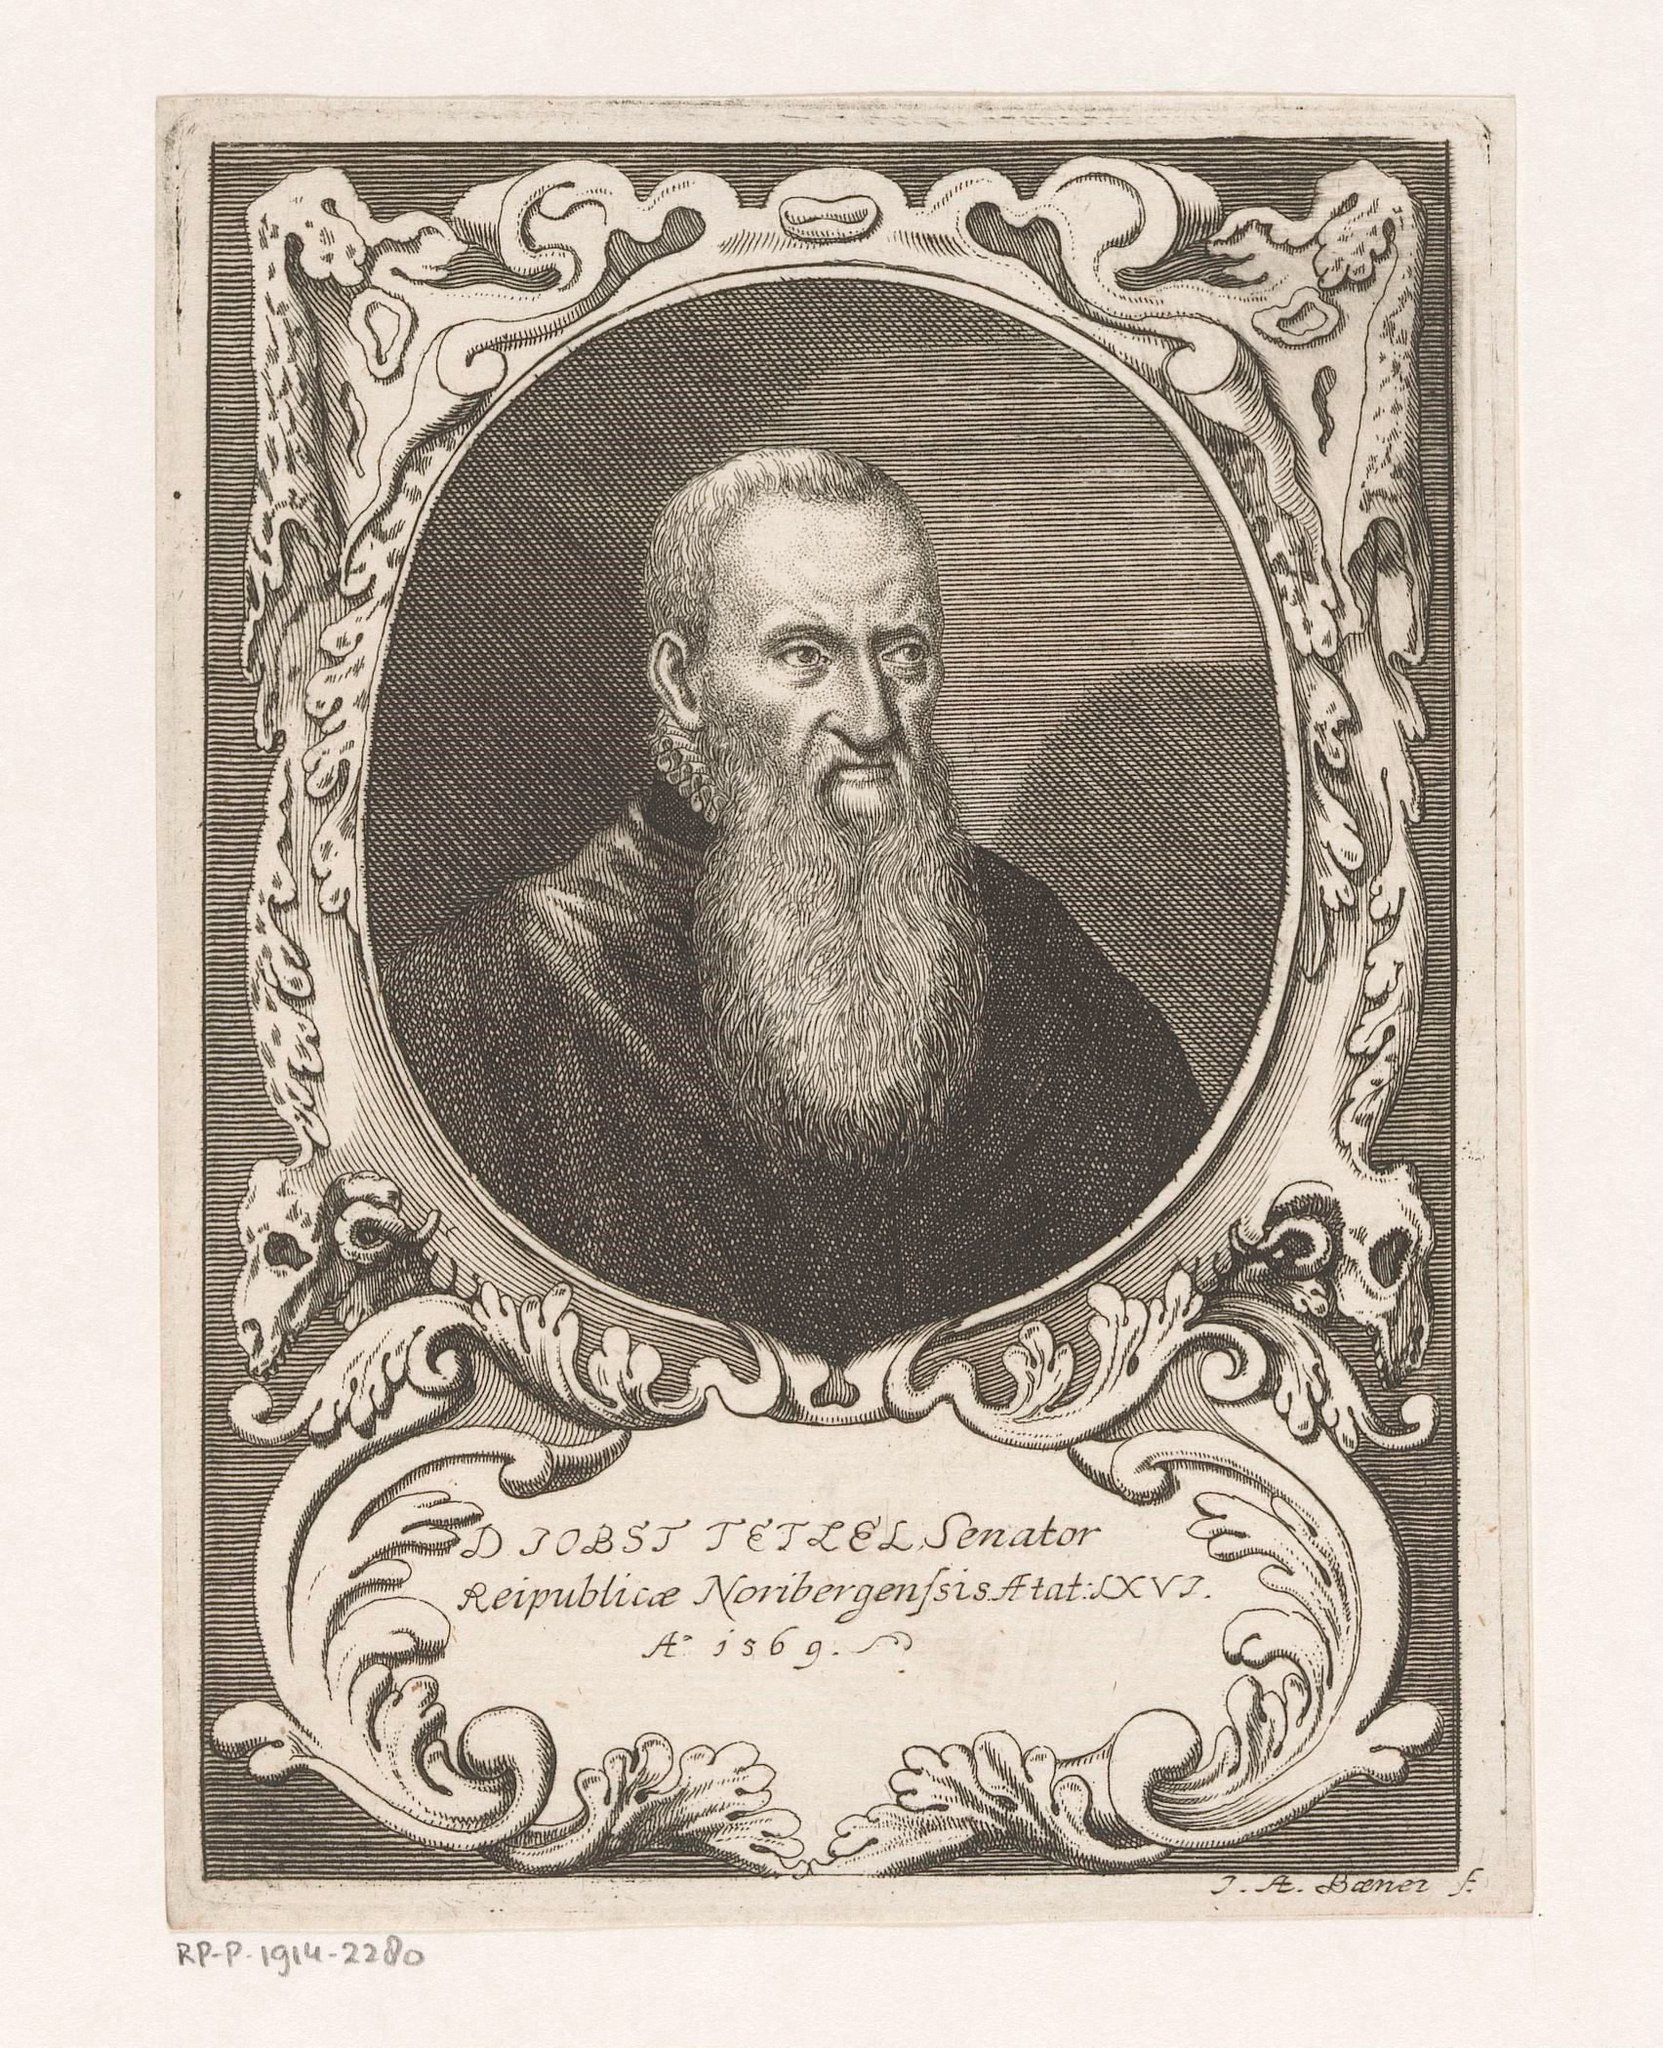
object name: print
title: Portret van Jobst Tetzel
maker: johann alexander böner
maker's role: draughtsman, print maker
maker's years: 1647-1720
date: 1657-1720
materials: paper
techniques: engraving, etching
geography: nuremberg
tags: historical persons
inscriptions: collector's mark: Lugt 2228